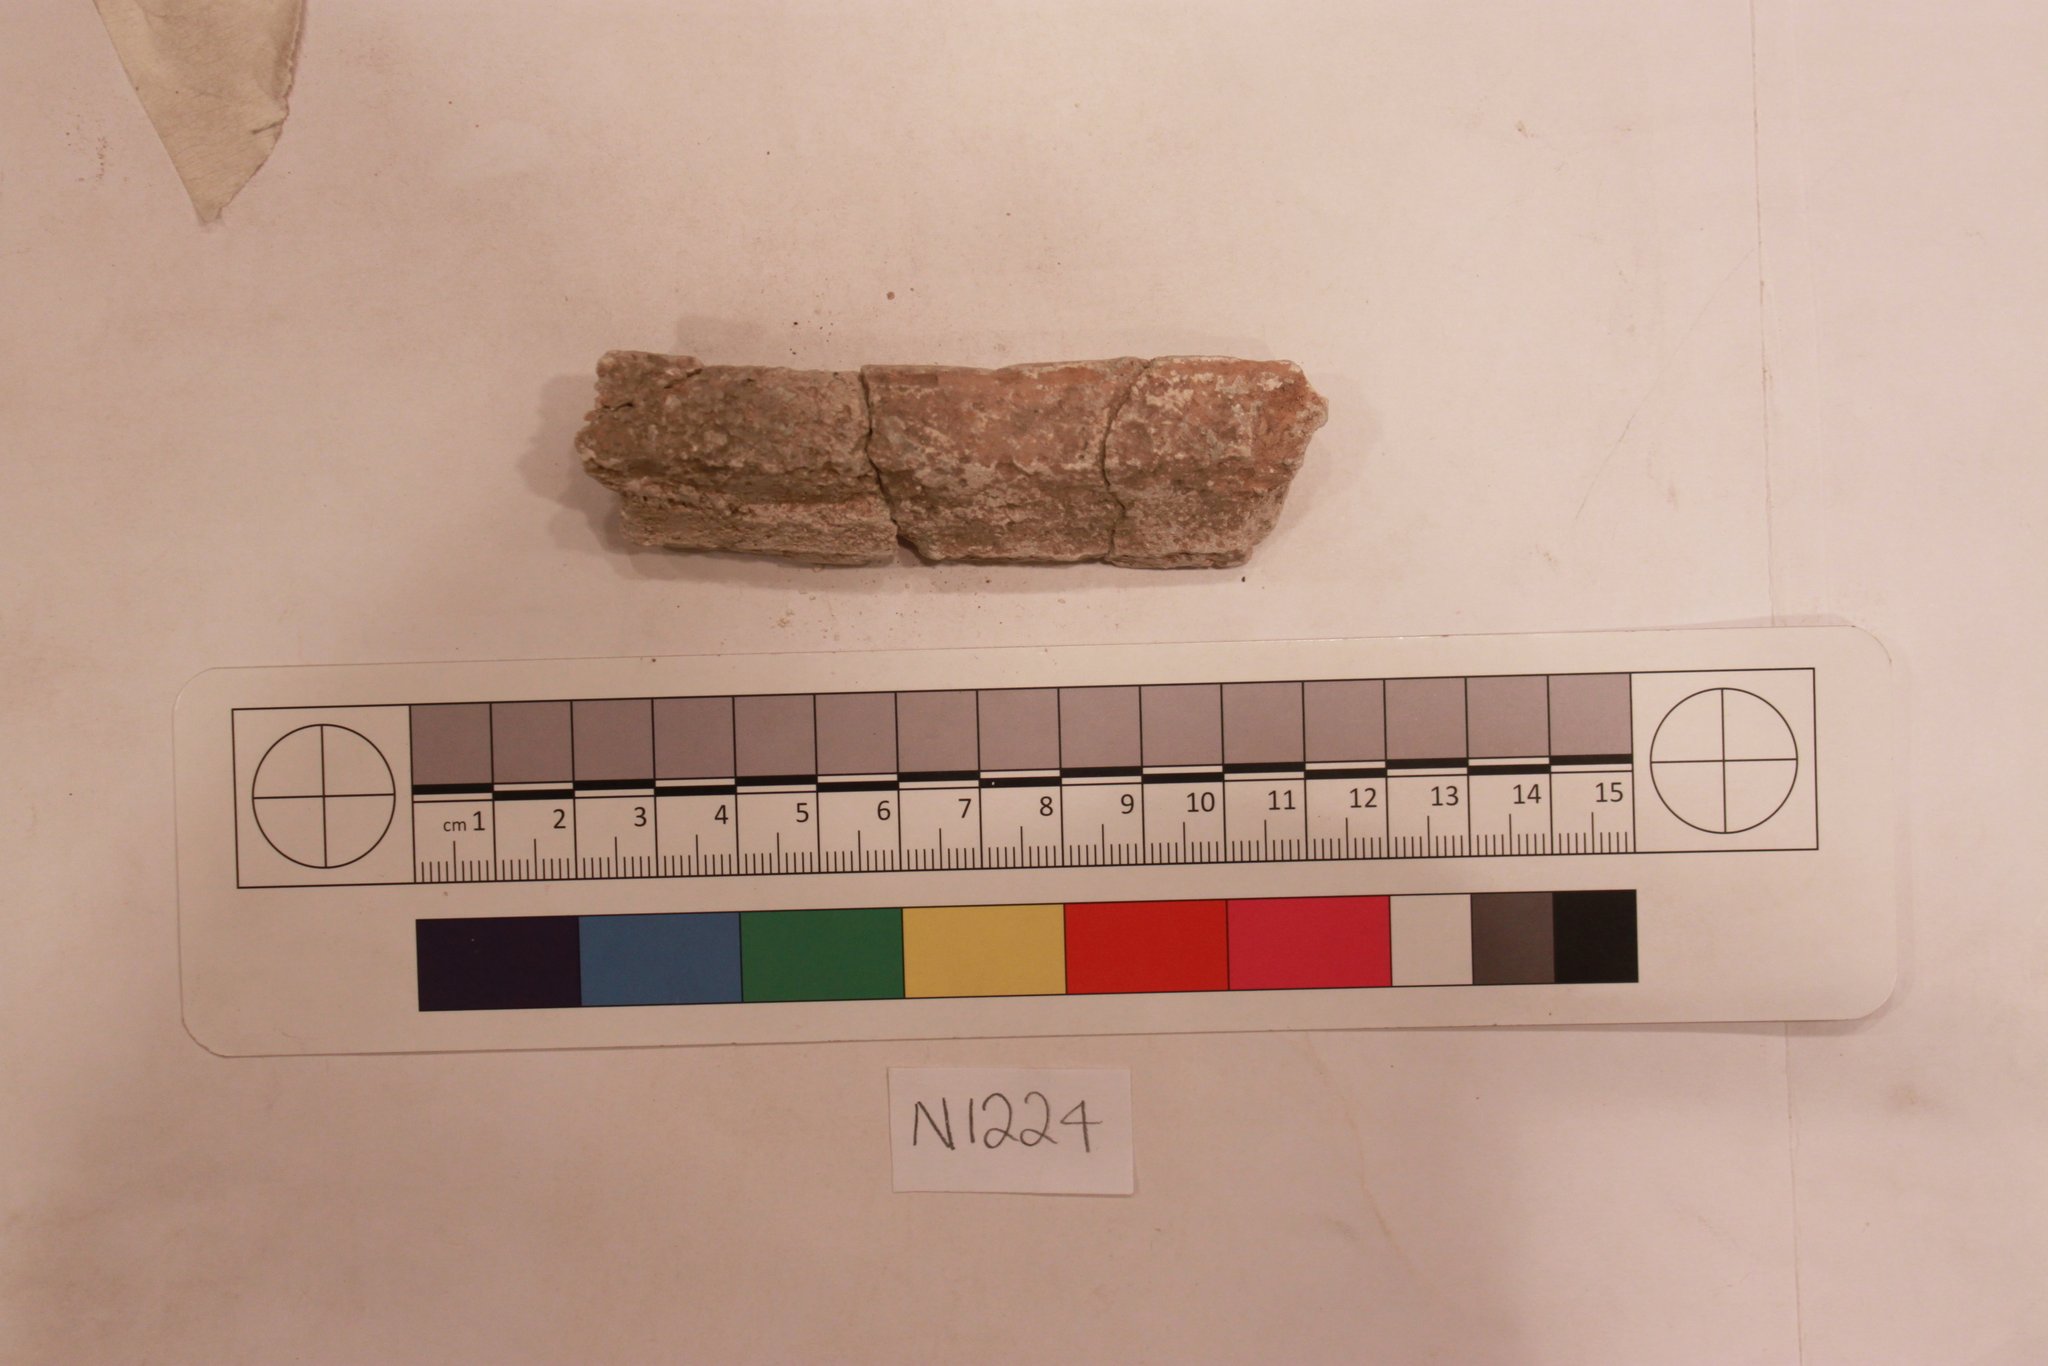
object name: fragment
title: Stucco Fragment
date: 701-1200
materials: plaster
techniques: carving, painting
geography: iran